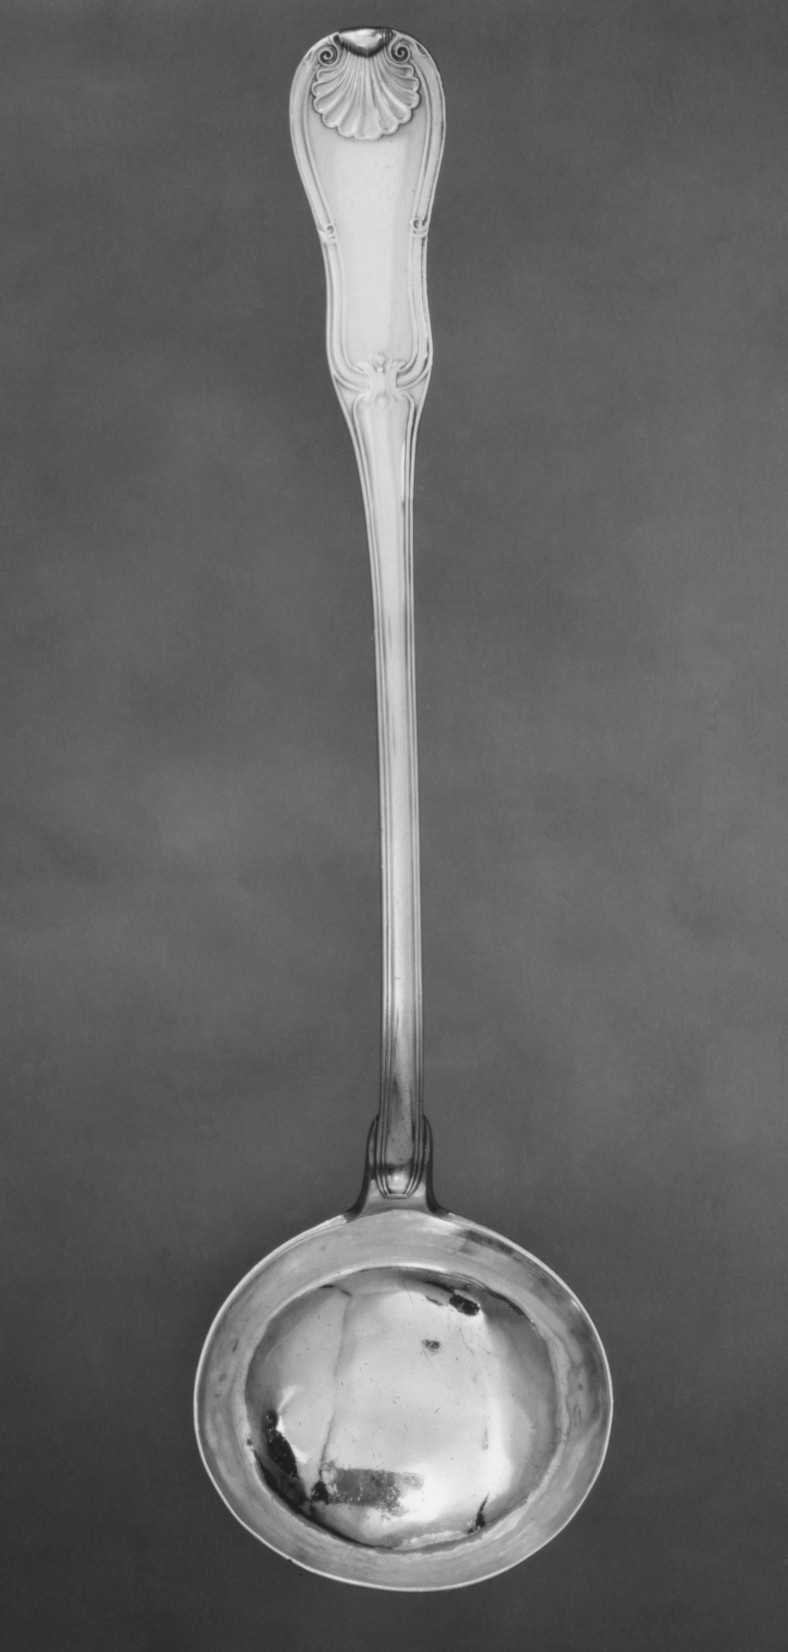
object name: ladle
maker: nicolas collier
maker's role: maker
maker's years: 1733-1833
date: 1767-1768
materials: silver